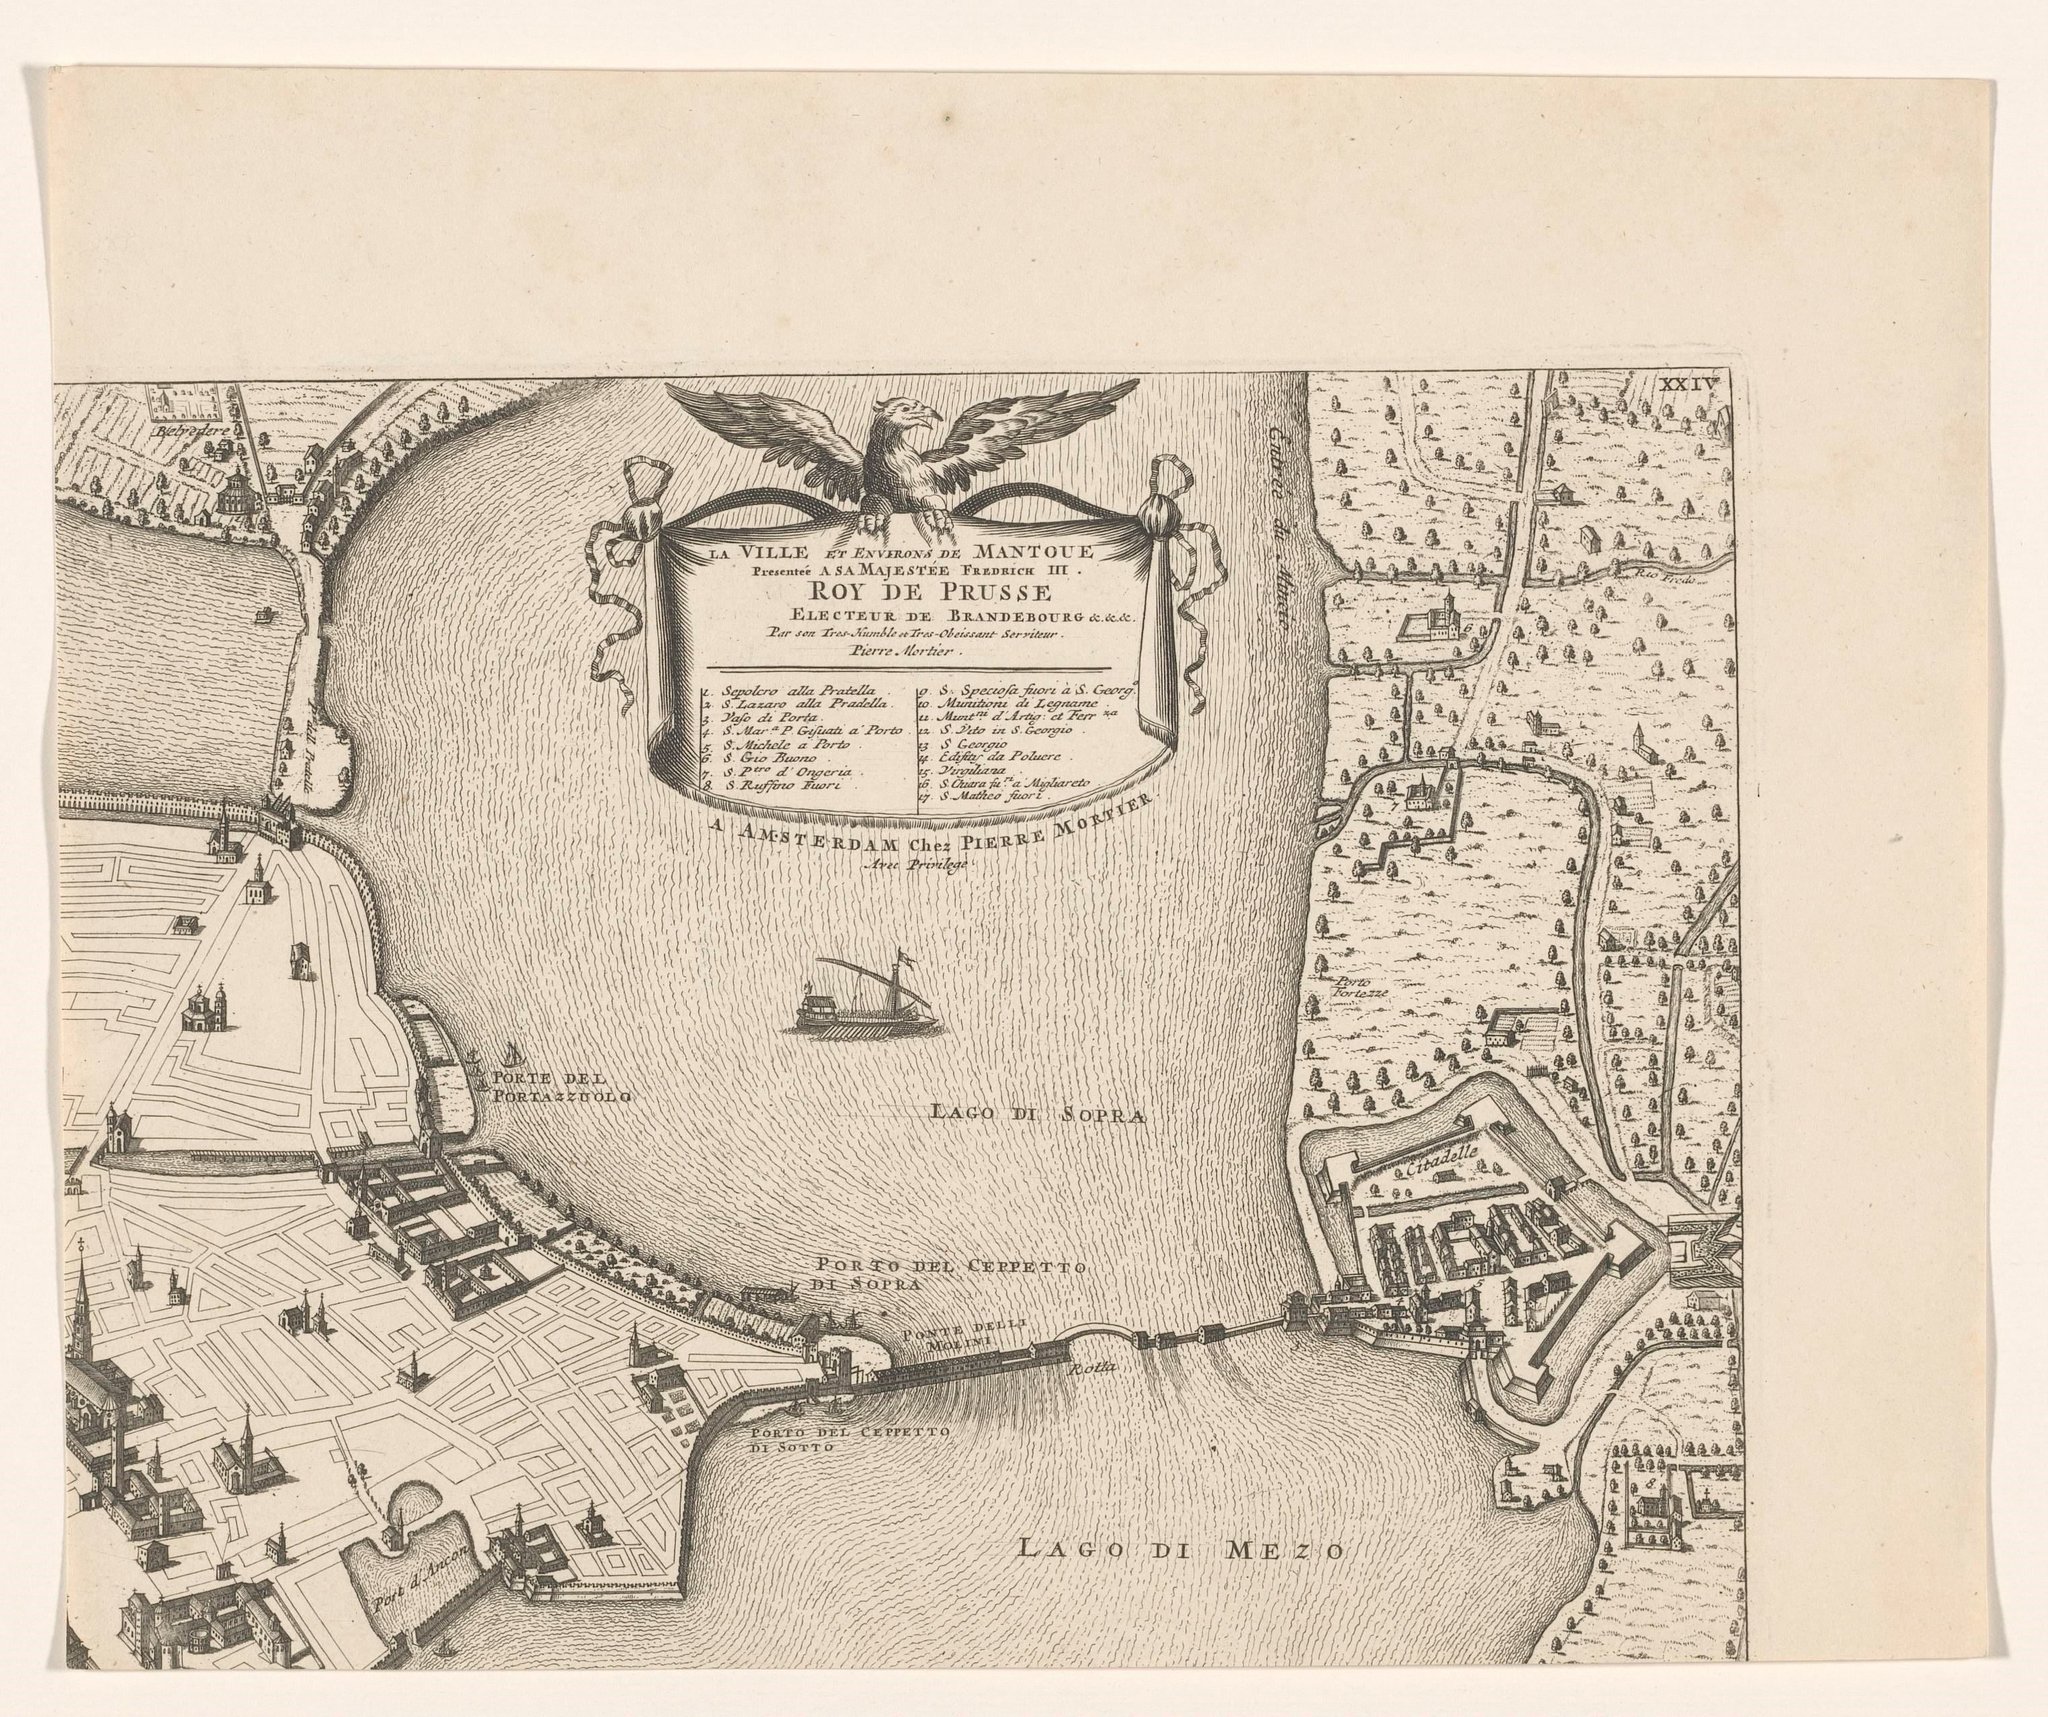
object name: area plan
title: La ville et environs de Mantoue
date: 1704-1724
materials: paper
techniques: engraving, etching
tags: harbour, maps of cities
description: Deel rechtsboven van een plattegrond van de stad en omgeving van Mantua, gesneden in vier delen. Rechtsboven genummerd: XXIV.